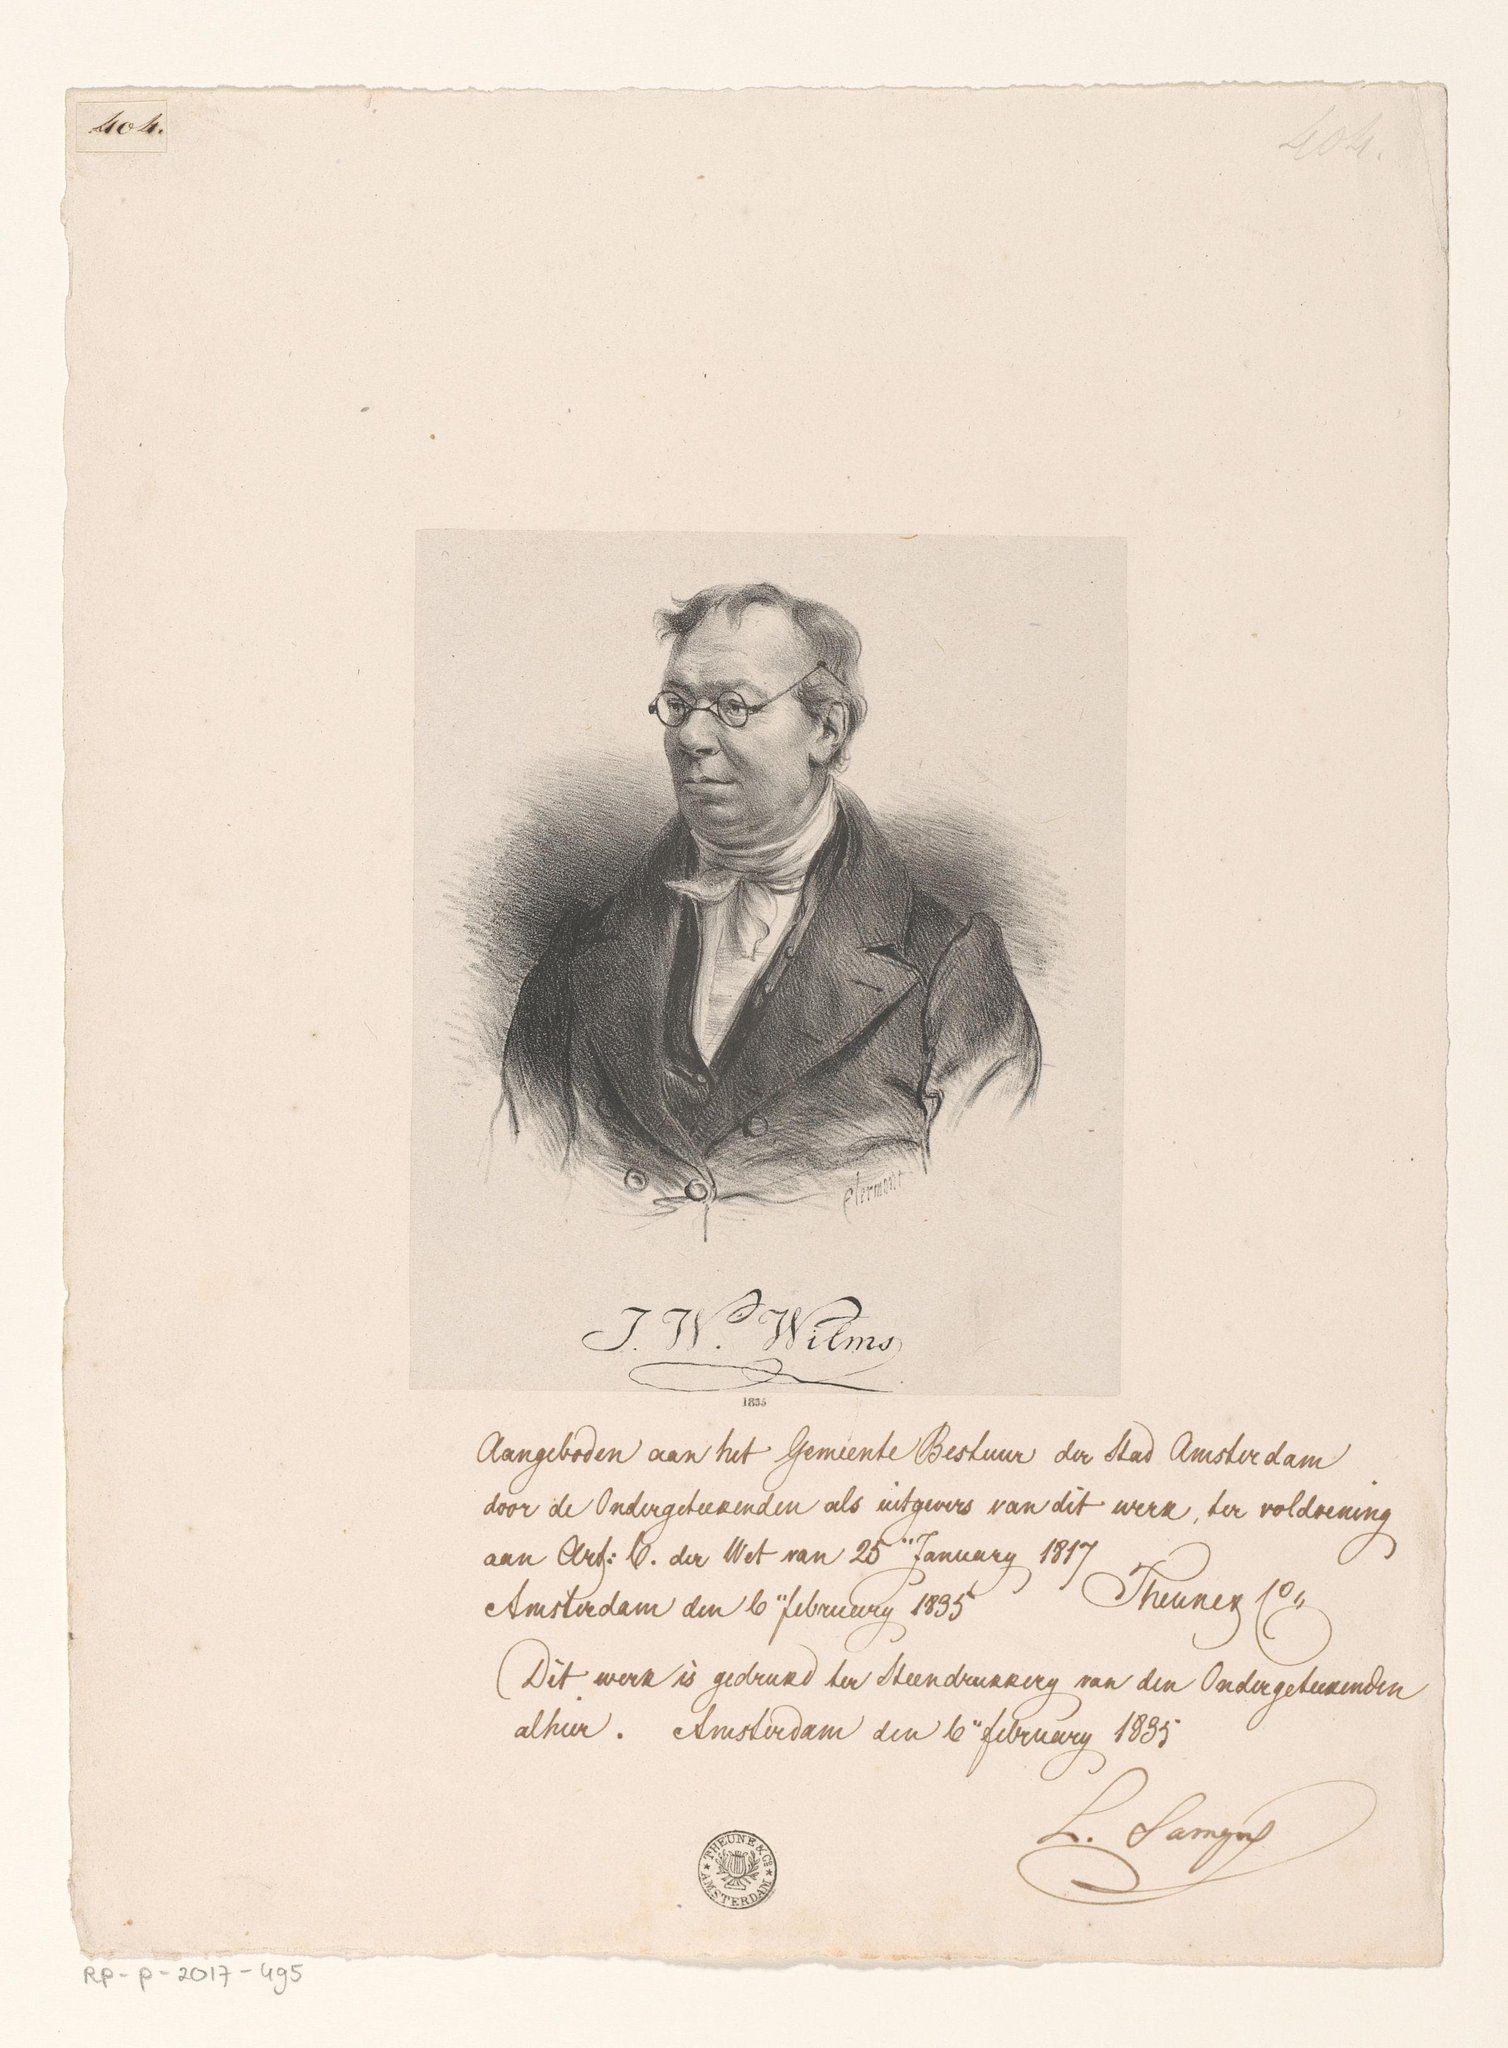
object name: print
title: Portret van Johann Wilhelm Wilms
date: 1835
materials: paper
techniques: lithograph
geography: amsterdam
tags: eyeglasses, spectacles, historical persons (+ (full) bust portrait)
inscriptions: : ‘Aangeboden aan het gemeente bestuur der stad Amsterdam / door de ondergeteekenden als uitgevers van dit werk, ter voldoening / aan Art: 6 der wet van 25 january 1817 / Amsterdam den 6 february 1835 / Theune & Comp’, : ‘Dit werk is gedrukt ter steendrukkerij van den ondergeteekenden / alhier. Amsterdam den 6 february 1835 / L Samijn’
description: De geportretteerde kijkt naar links en draagt een bril. Onder het portret zijn signatuur.